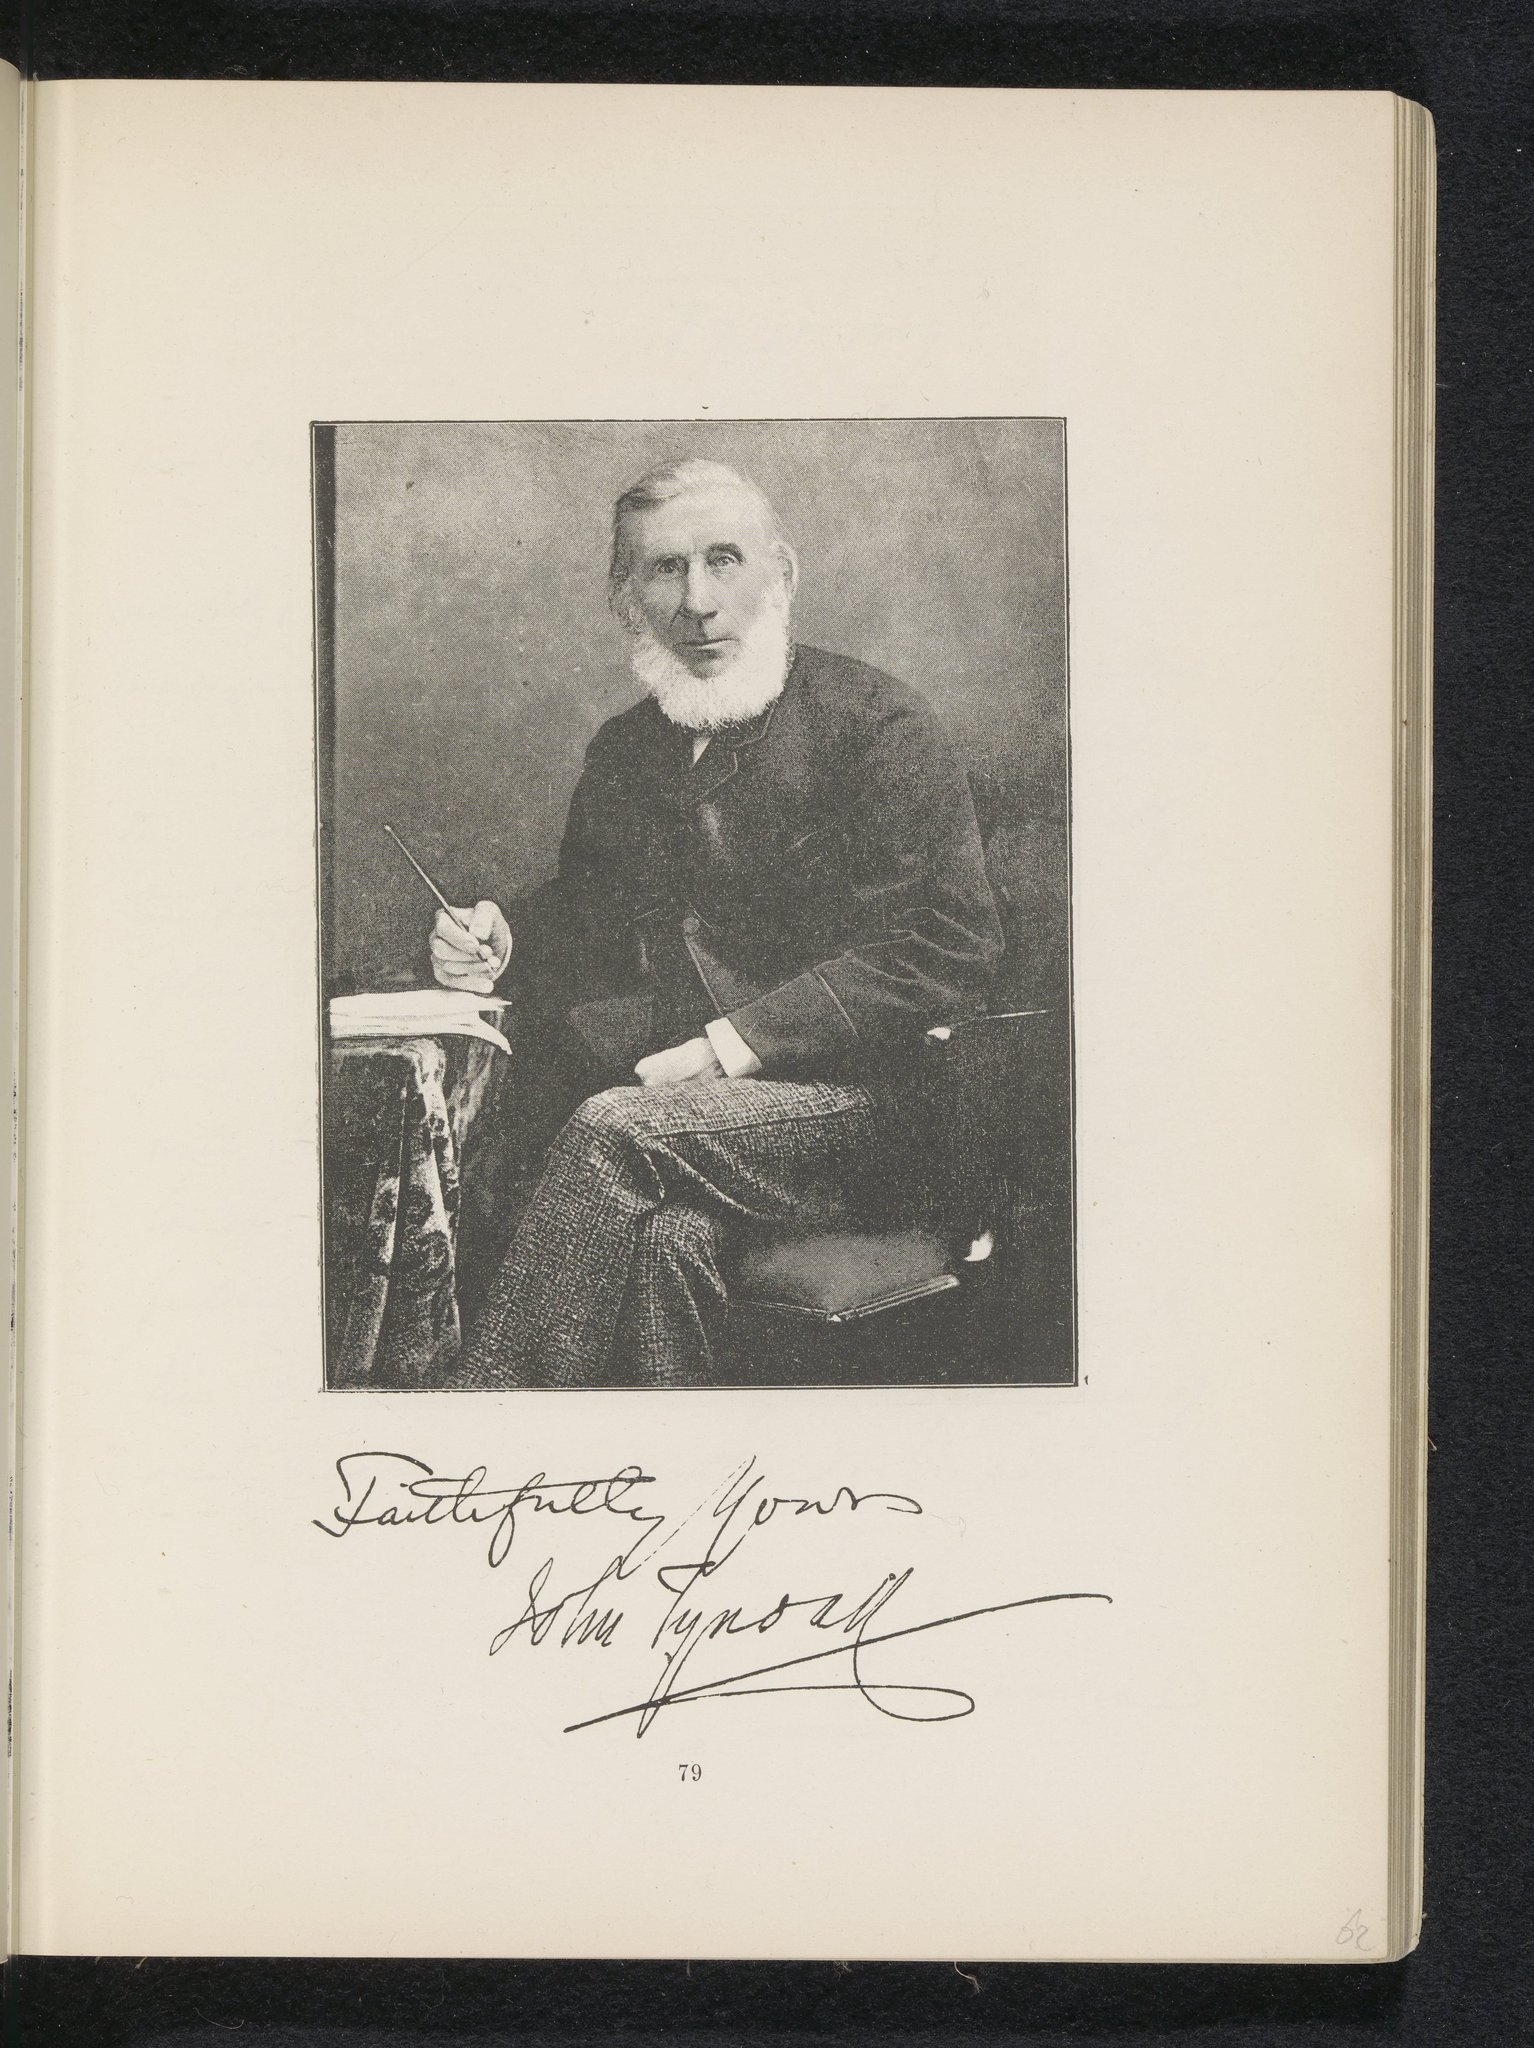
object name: photomechanical print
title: Portret van John Tyndall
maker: Anonymous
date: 1881-1891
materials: paper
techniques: autotype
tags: portrait, self-portrait of architect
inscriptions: inscription